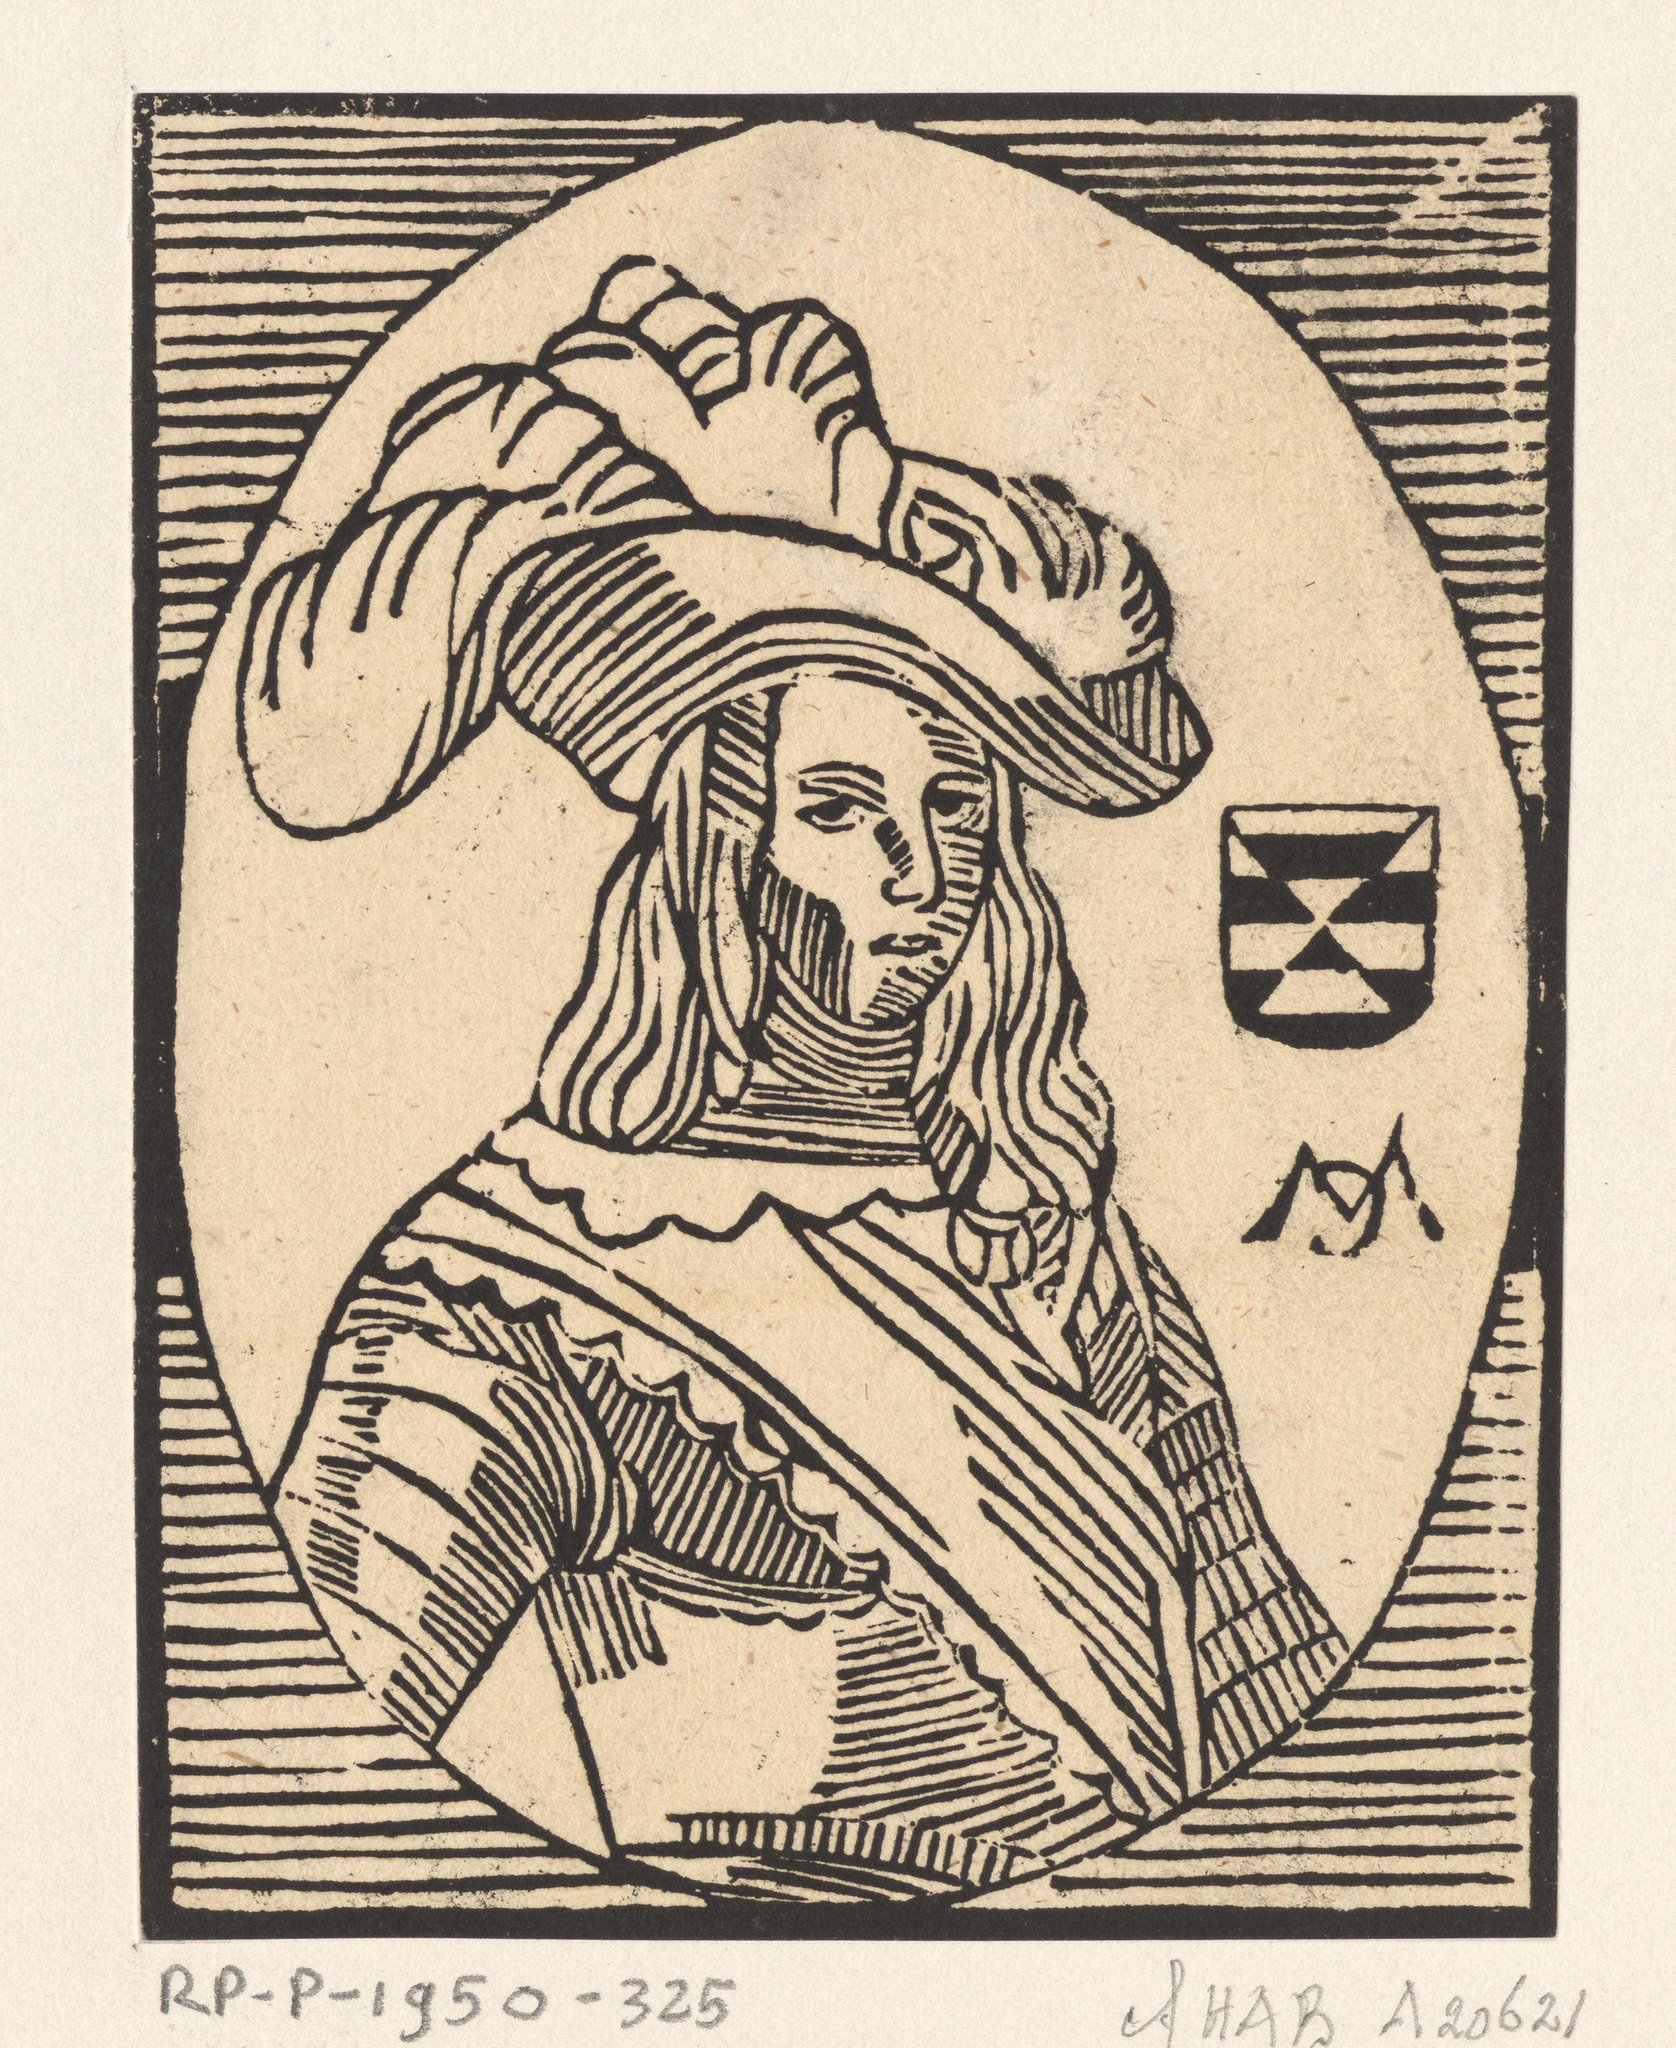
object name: print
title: Portret van Don Juan II van Oostenrijk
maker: Anonymous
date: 1650-1749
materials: paper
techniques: woodcut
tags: historical persons, head-gear: hat, ruler, sovereign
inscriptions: monogram